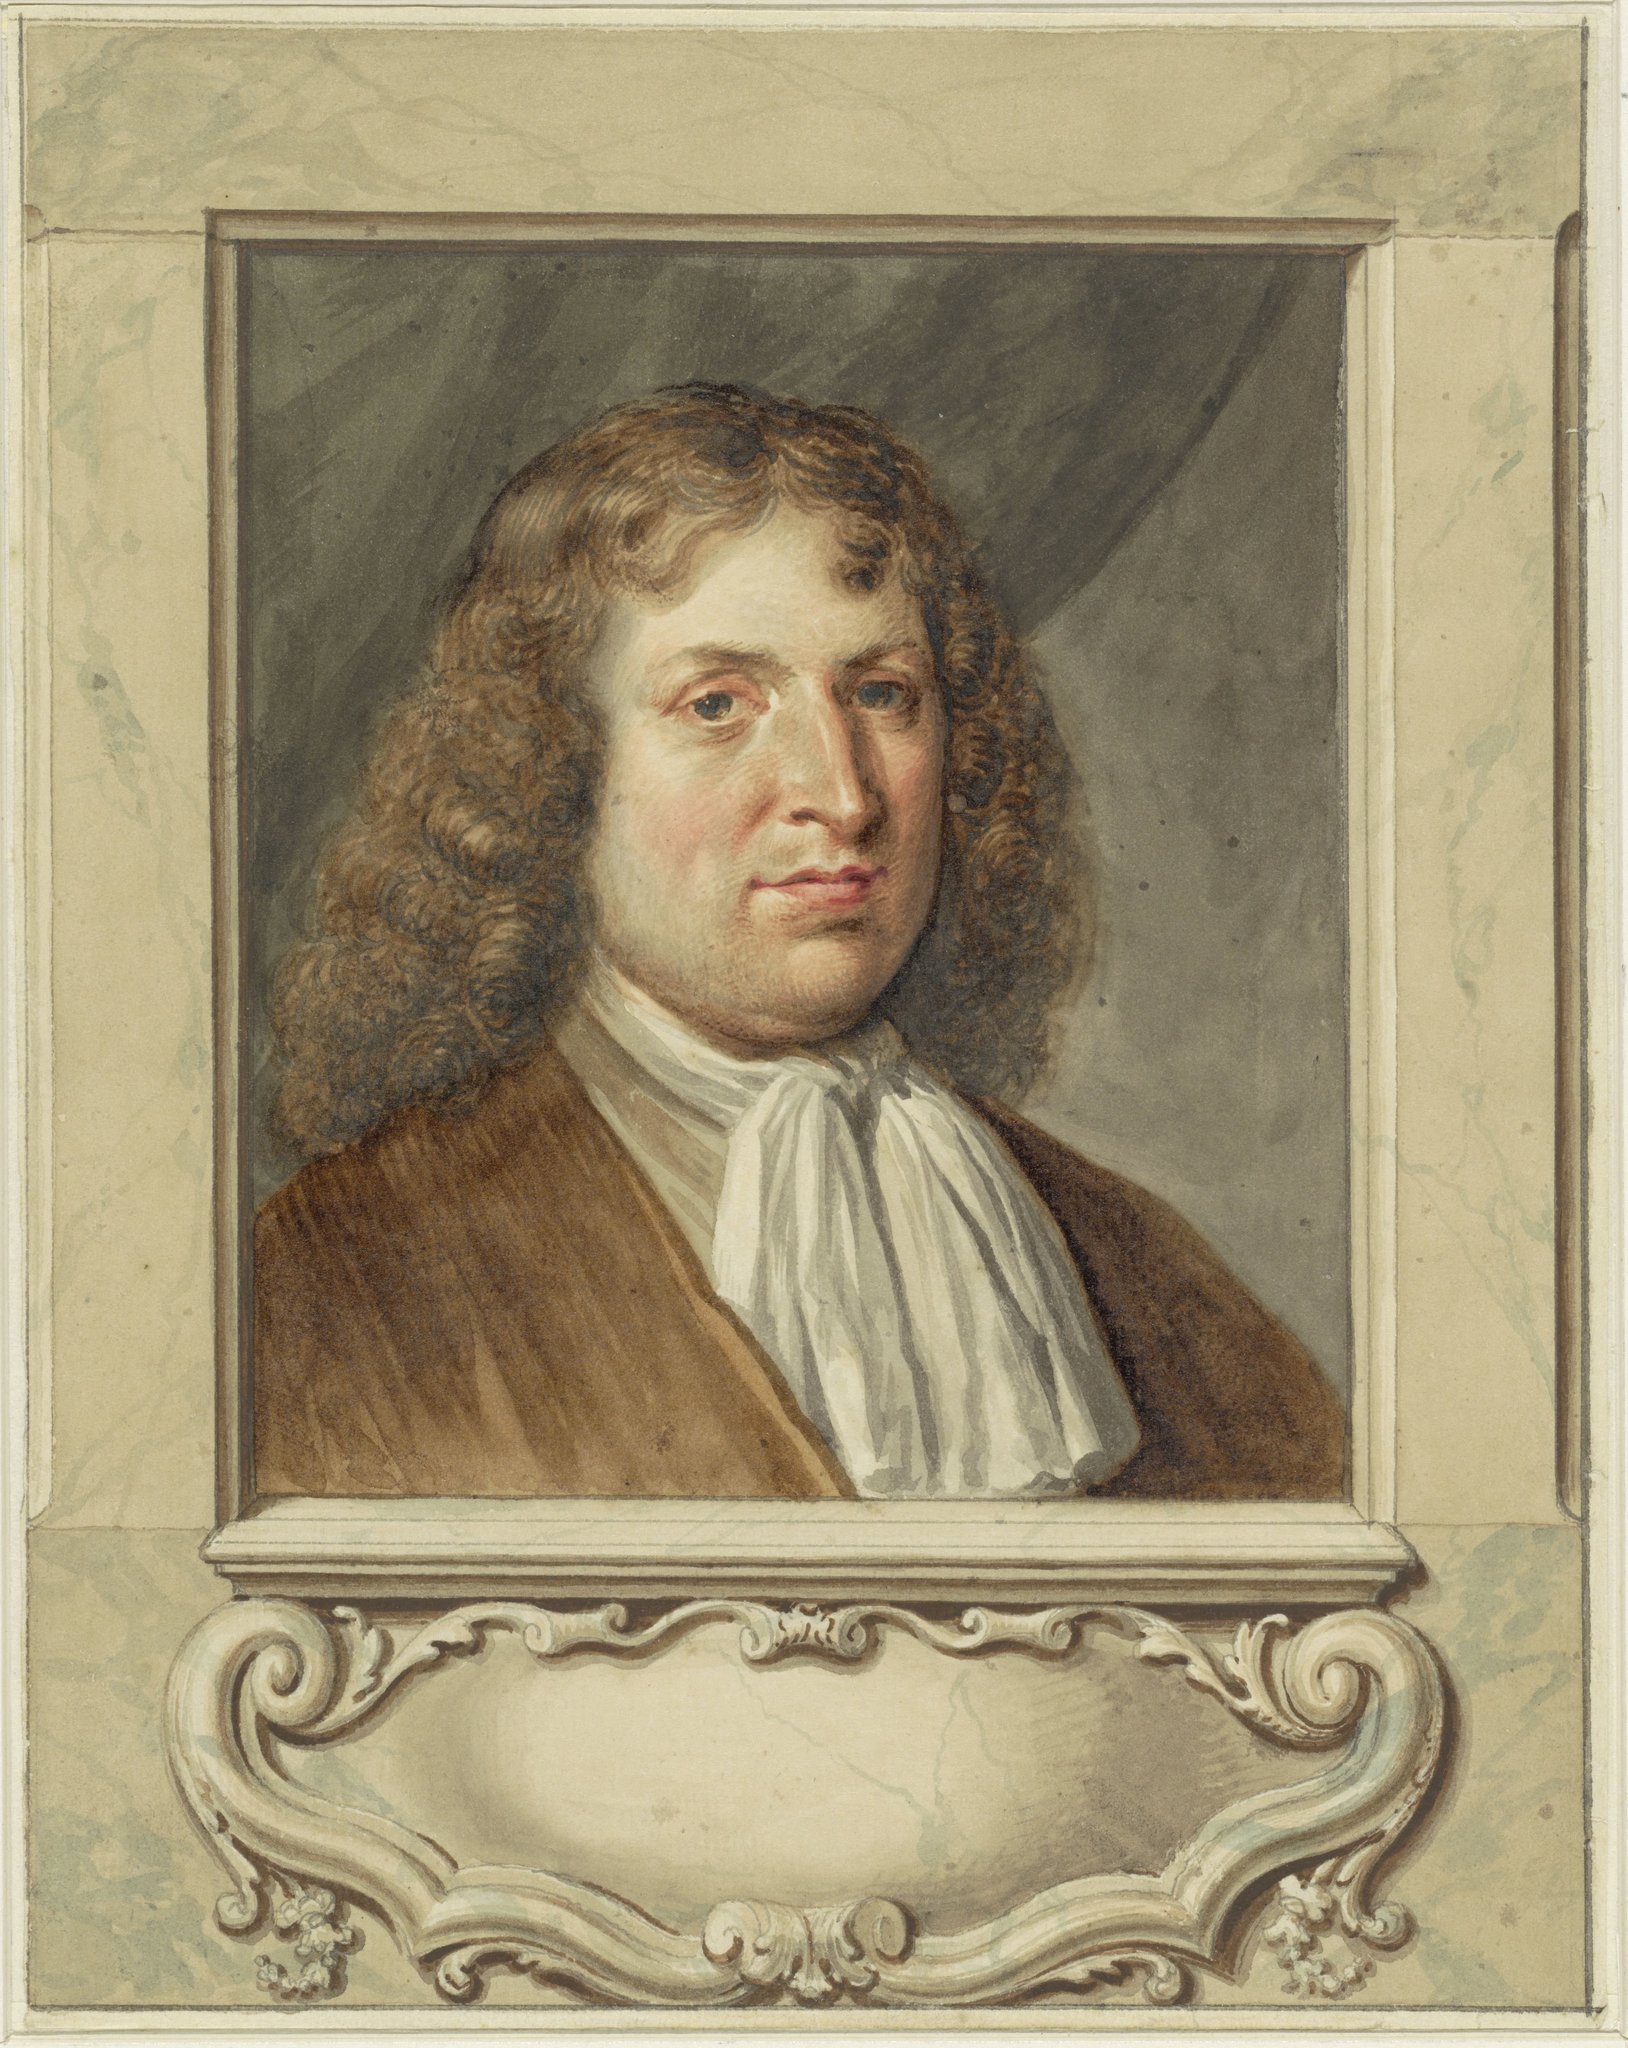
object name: watercolor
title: Portret van Victor Victors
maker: tako hajo jelgersma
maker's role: draughtsman, painter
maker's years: 1702-1795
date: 1712-1795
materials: ink, paper, watercolor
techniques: brush, pen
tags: amsterdam, victor victors, historical persons, portrait, self-portrait of painter, portrait, self-portrait of artist